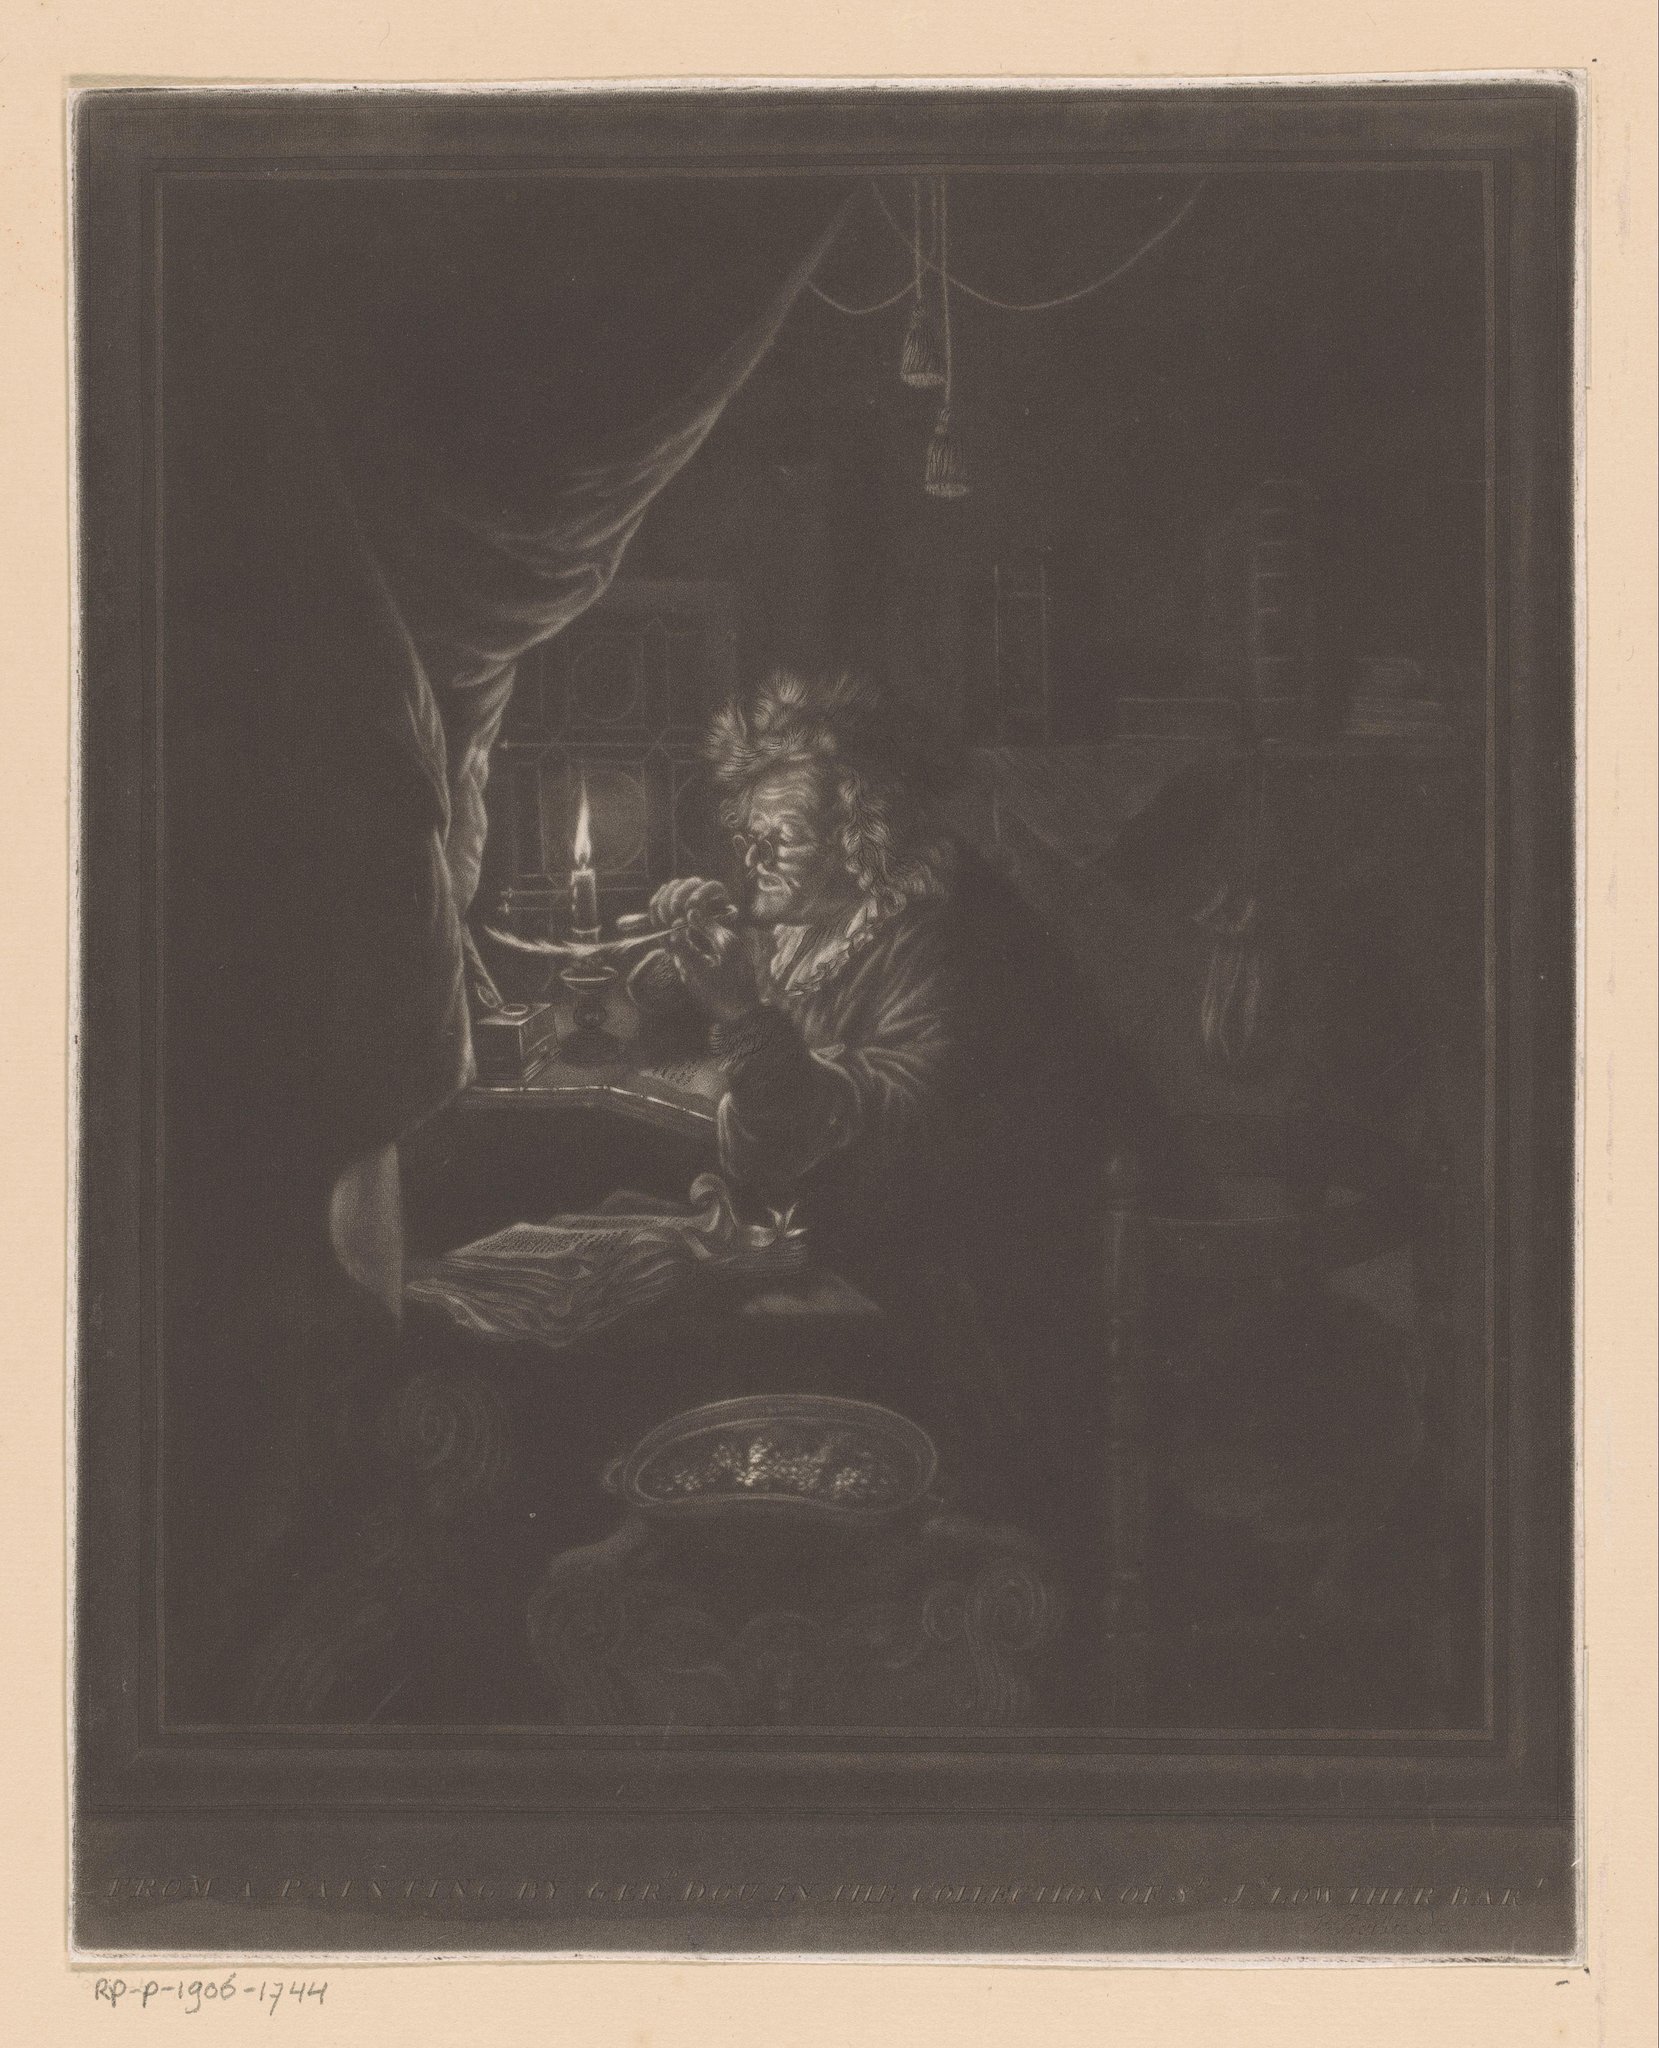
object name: print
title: Penversnijder in studievertrek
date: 1750-1810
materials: paper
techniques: engraving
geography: england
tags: candle, sharpening pen (quill)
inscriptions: collector's mark: Lugt 2228